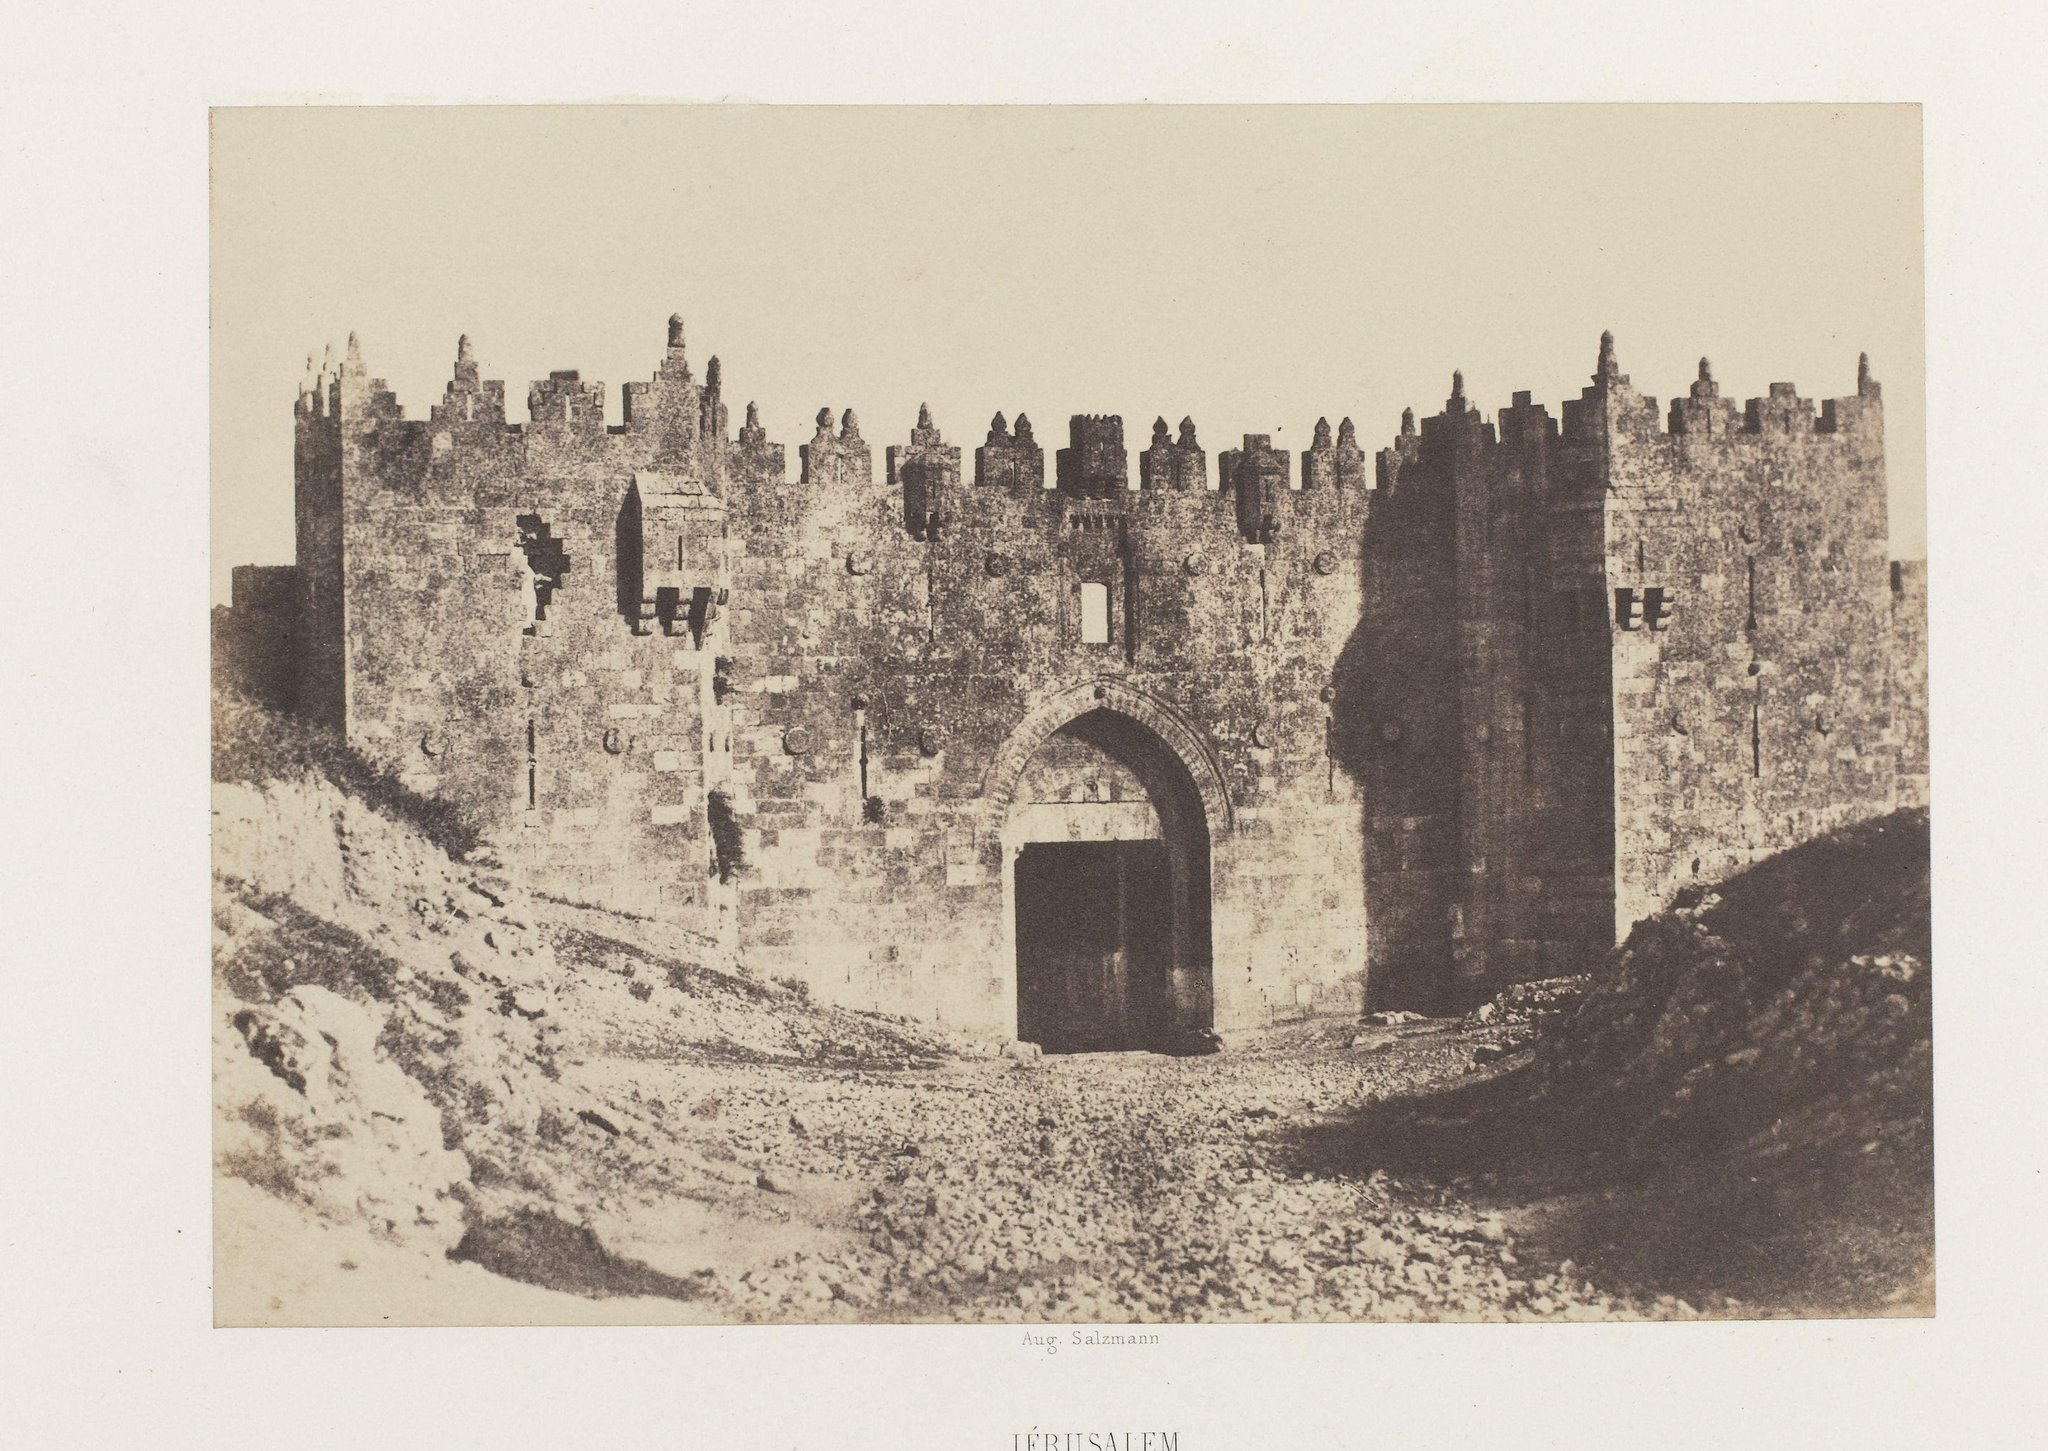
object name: page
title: Jérusalem. Porte de Damas. Vue extérieure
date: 1854-1856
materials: cardboard, paper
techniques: salted paper print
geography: jerusalem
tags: gate, entrance, city-gate